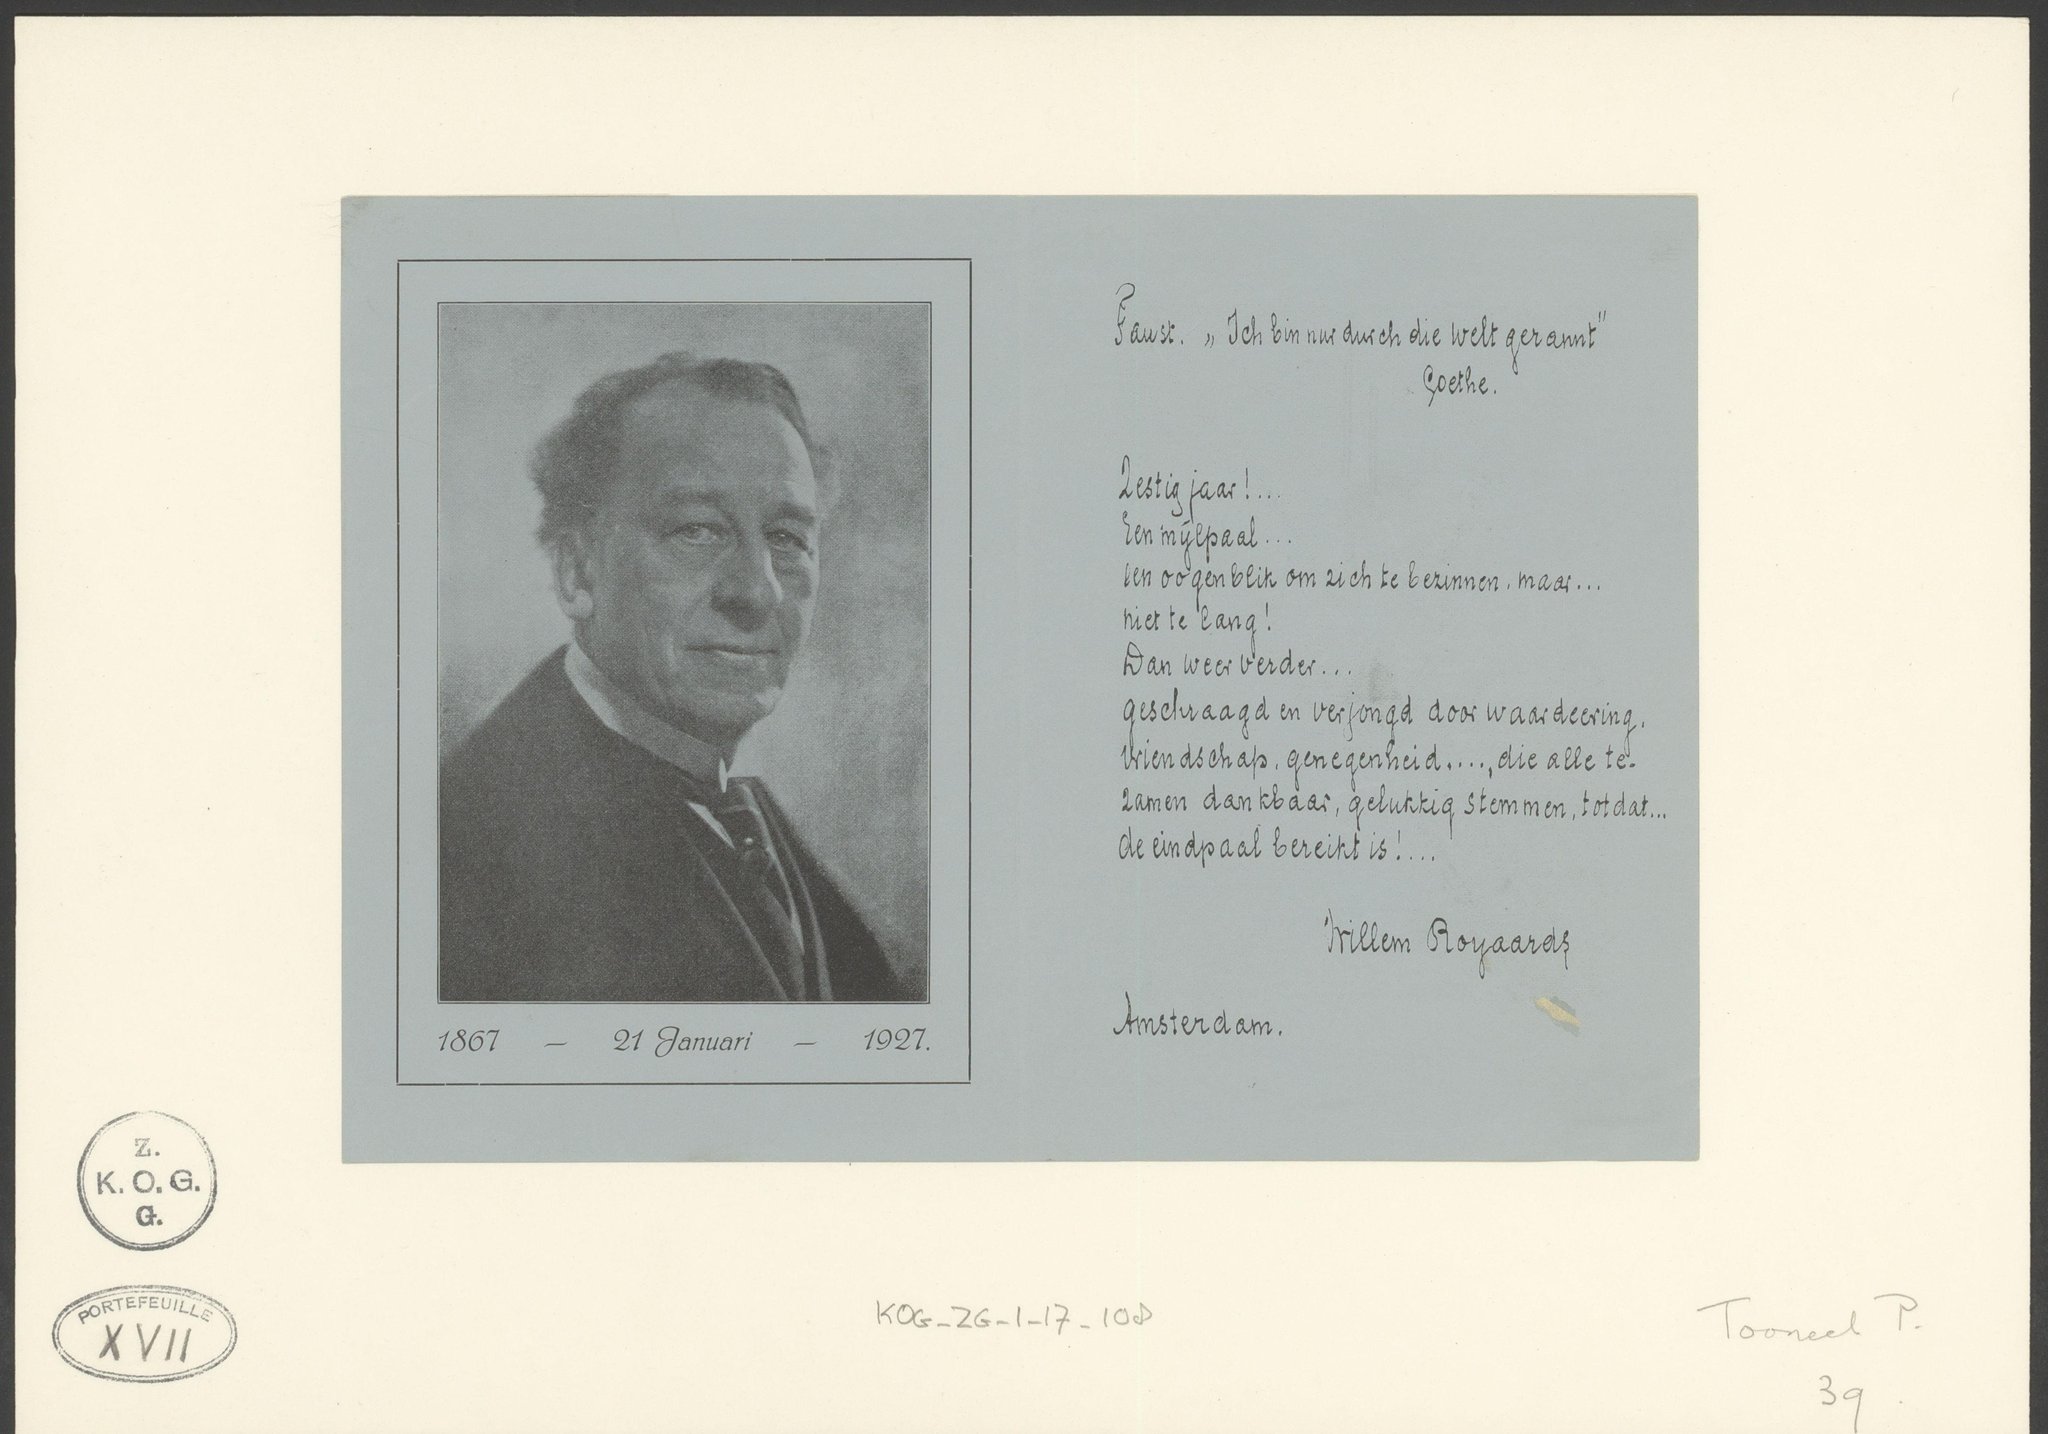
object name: photomechanical print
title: Portret van Willem Royaards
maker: Anonymous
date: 1927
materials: paper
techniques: offset printed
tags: willem cornelis royaards, historical persons, portrait of actor, actress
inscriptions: stamp, collector's mark: Lugt 1641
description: Verjaardagkaart voor de zestigste verjaardag van de acteur Willem Royaards, 1927. Onderwerpsrubrieken binnen de Atlas Zeden en Gewoonten: Tooneel, Portretten van toneelspelers.